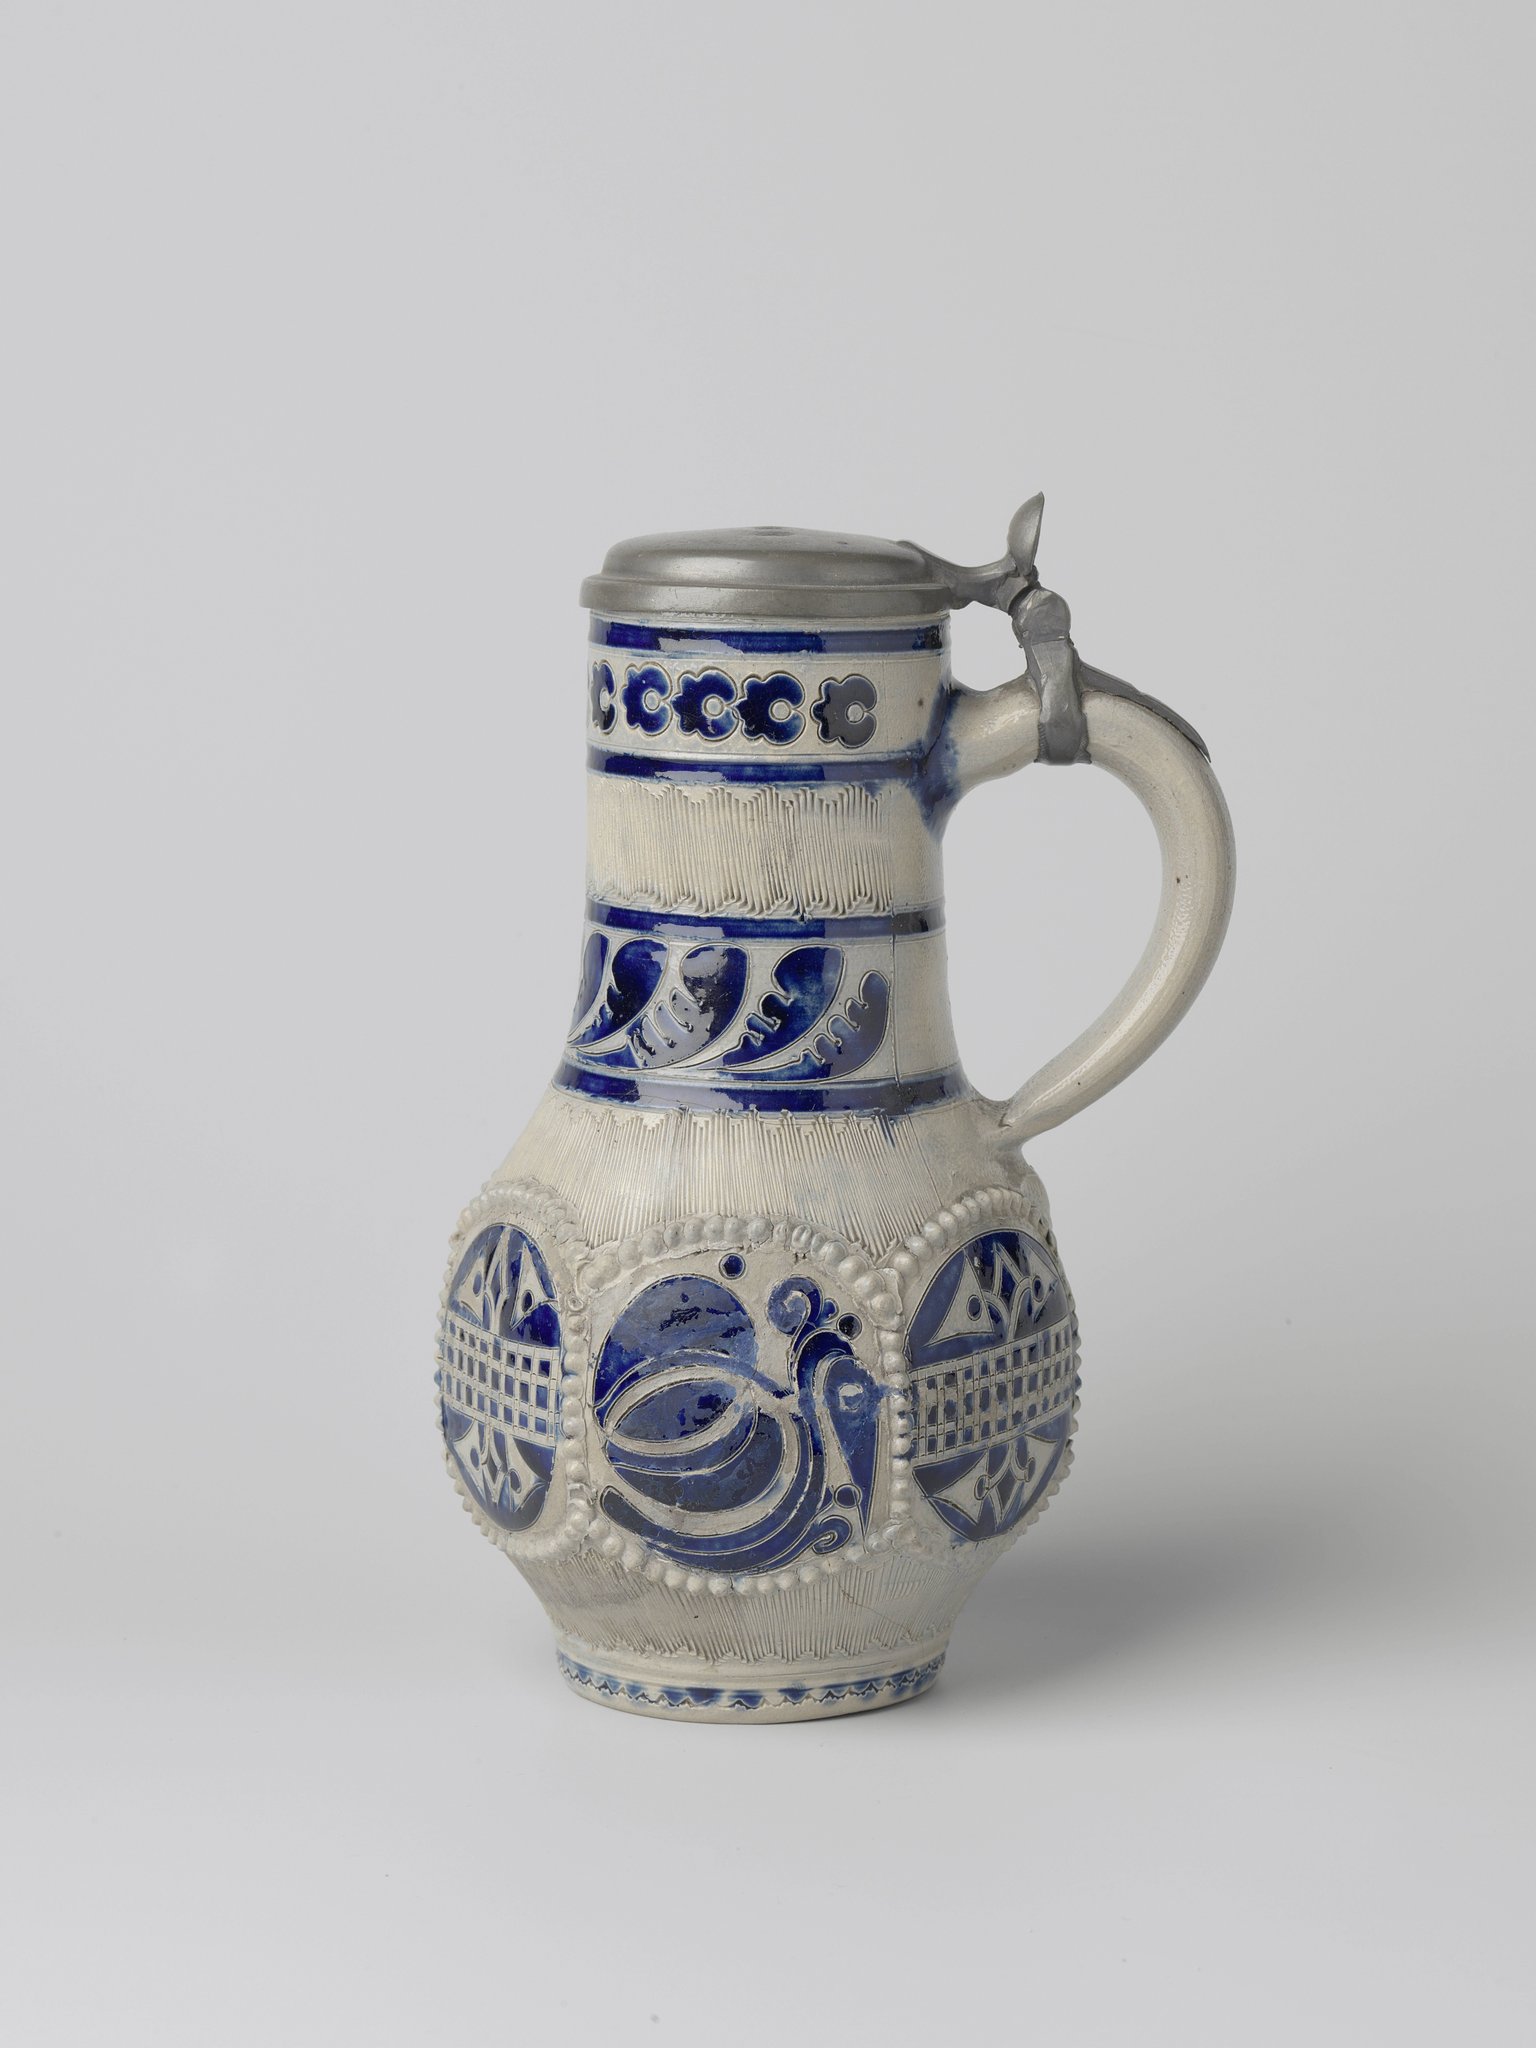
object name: jug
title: Jug with stylized flowers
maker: Anonymous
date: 1730-1770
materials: cobalt, glaze, stoneware, tin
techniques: firing, forming, relief, turning, vitrification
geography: lahntal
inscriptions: inscription: ‘M.A.S.’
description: Kruik van steengoed op standring met een bolvormig lichaam en lange, wijde nek. Het C-vormige oor is bevestigd aan de nek en de schouder. Gedeeltelijk bedekt met kobaltblauw. De buik is zeshoekig met op elke zijde een rond vak gevormd door een gedrukte en opgelegde band van bollen in reliëf. In de vakken afwisselend een ingegrifte, gestileerde decoratie van een bloemrank of planten bij een hek. Onder en boven deze decoratie een band met een ingedrukte zigzaglijn (knibis). De nek is verdeeld in drie banden met gestileerde bladranken, knibis of gestileerde bloemen. Een ingedrukte decoratieve band en blauwe stippen op de voet. Aan het oor is een tinnen montuur met deksel bevestigd. Op de deksel de geslagen letters 'M.A.S.'; de binnenzijde met een onleesbaar merk. Lahntal, Westerwald.